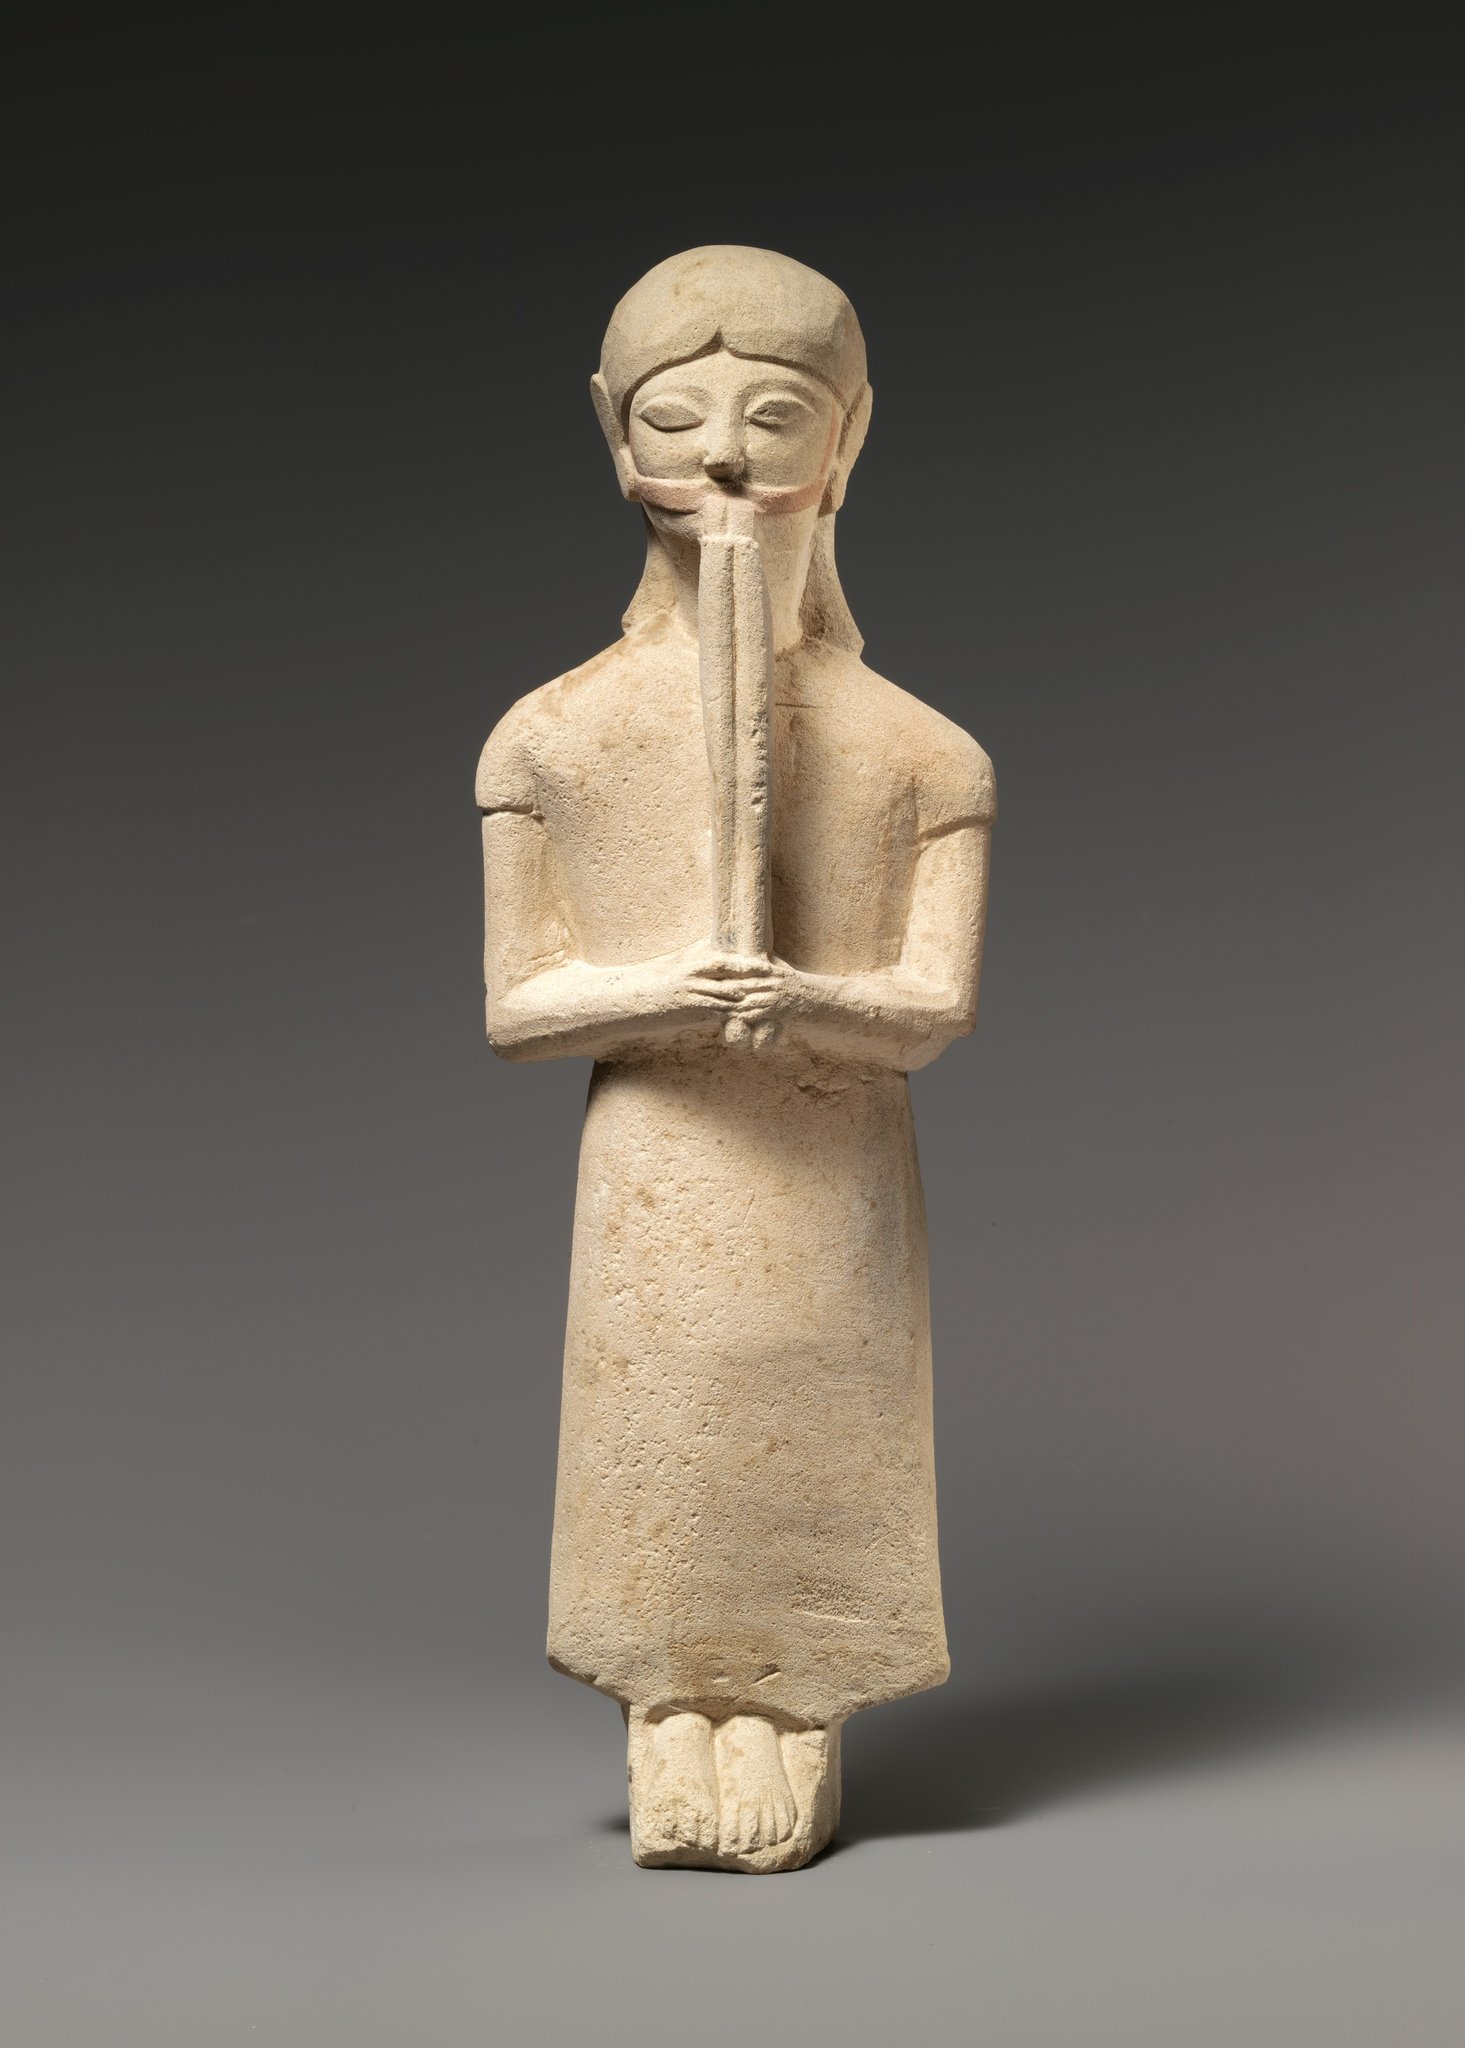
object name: statuette of a flute player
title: Limestone flute-player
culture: cypriot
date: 600-551 BCE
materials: limestone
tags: men,flutes,musicians